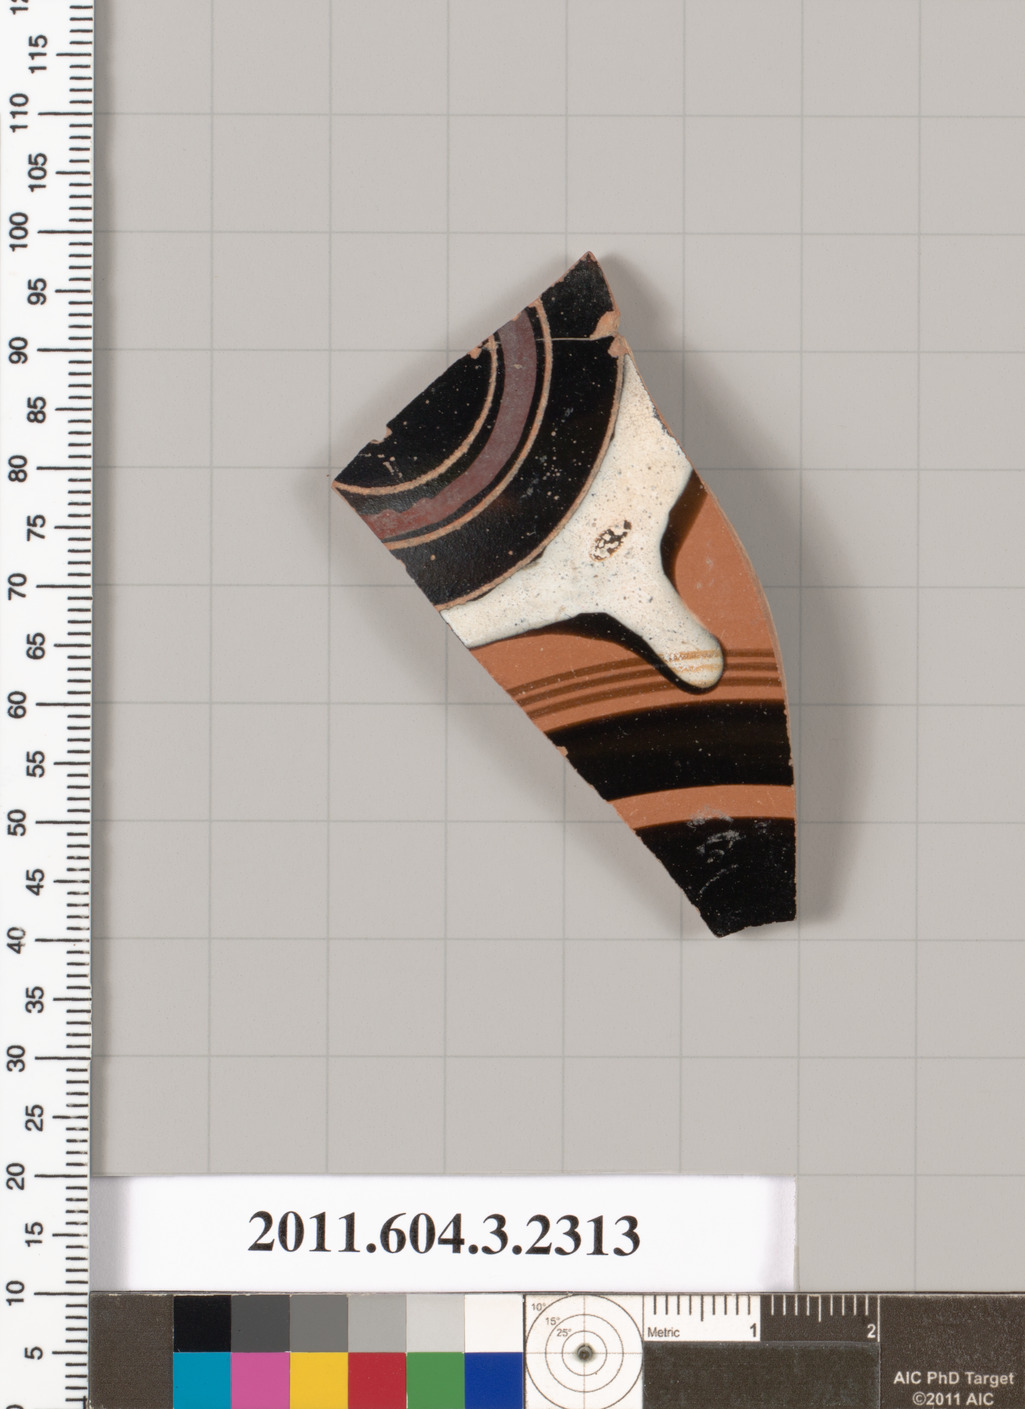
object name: kylix fragment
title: Terracotta fragment of a kylix: eye-cup (drinking cup)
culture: greek, attic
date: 540-520 BCE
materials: terracotta